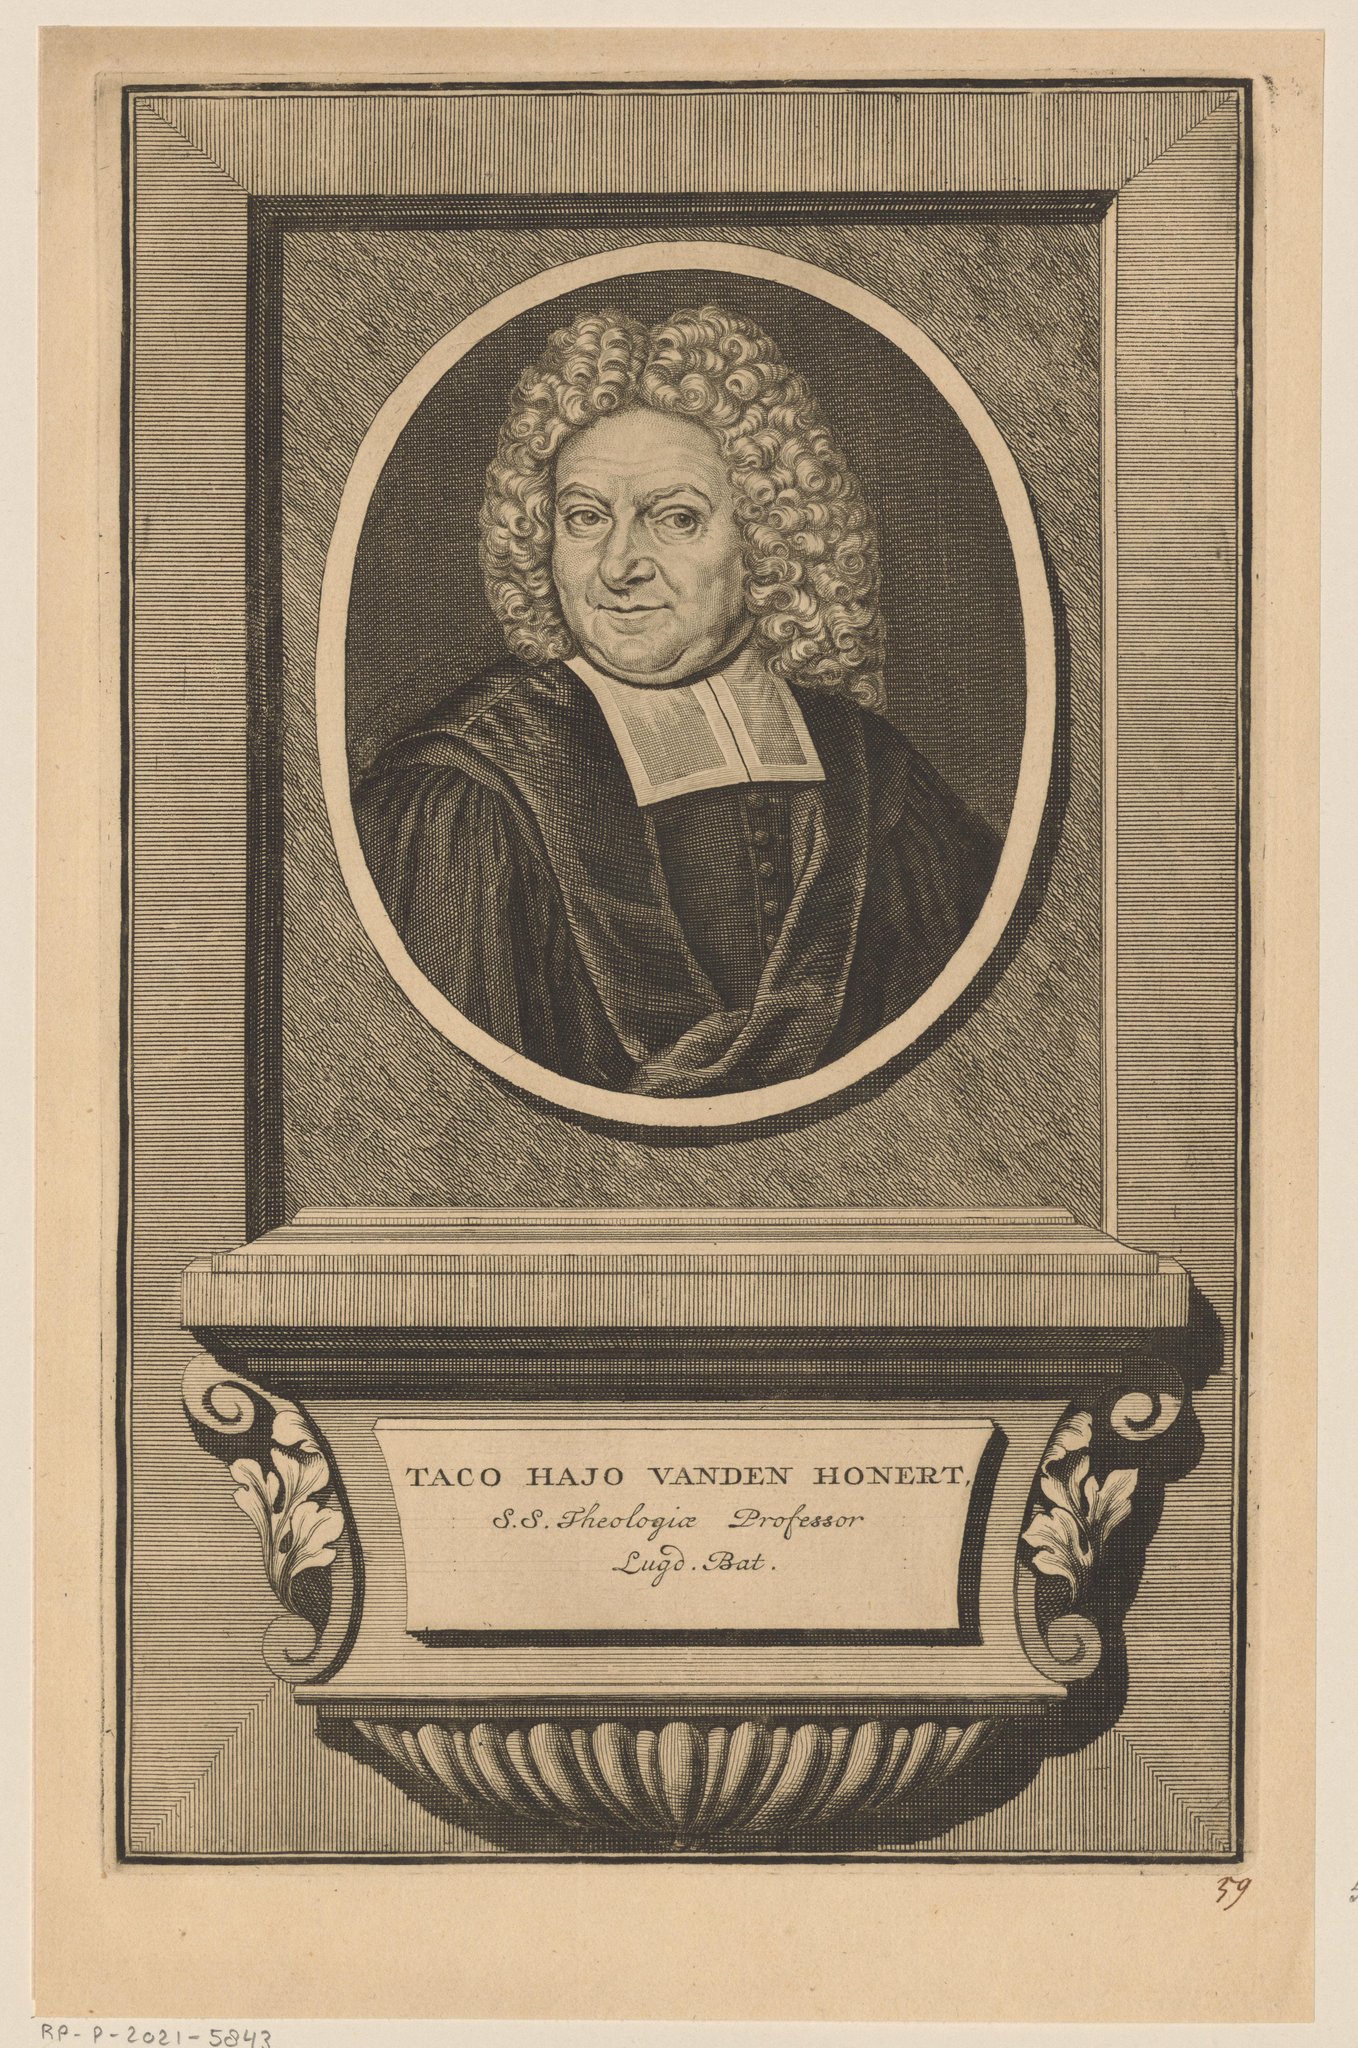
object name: print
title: Portret van Taco Hajo van den Honert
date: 1716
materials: paper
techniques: engraving, etching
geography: leiden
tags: leiden, theologian, historical persons